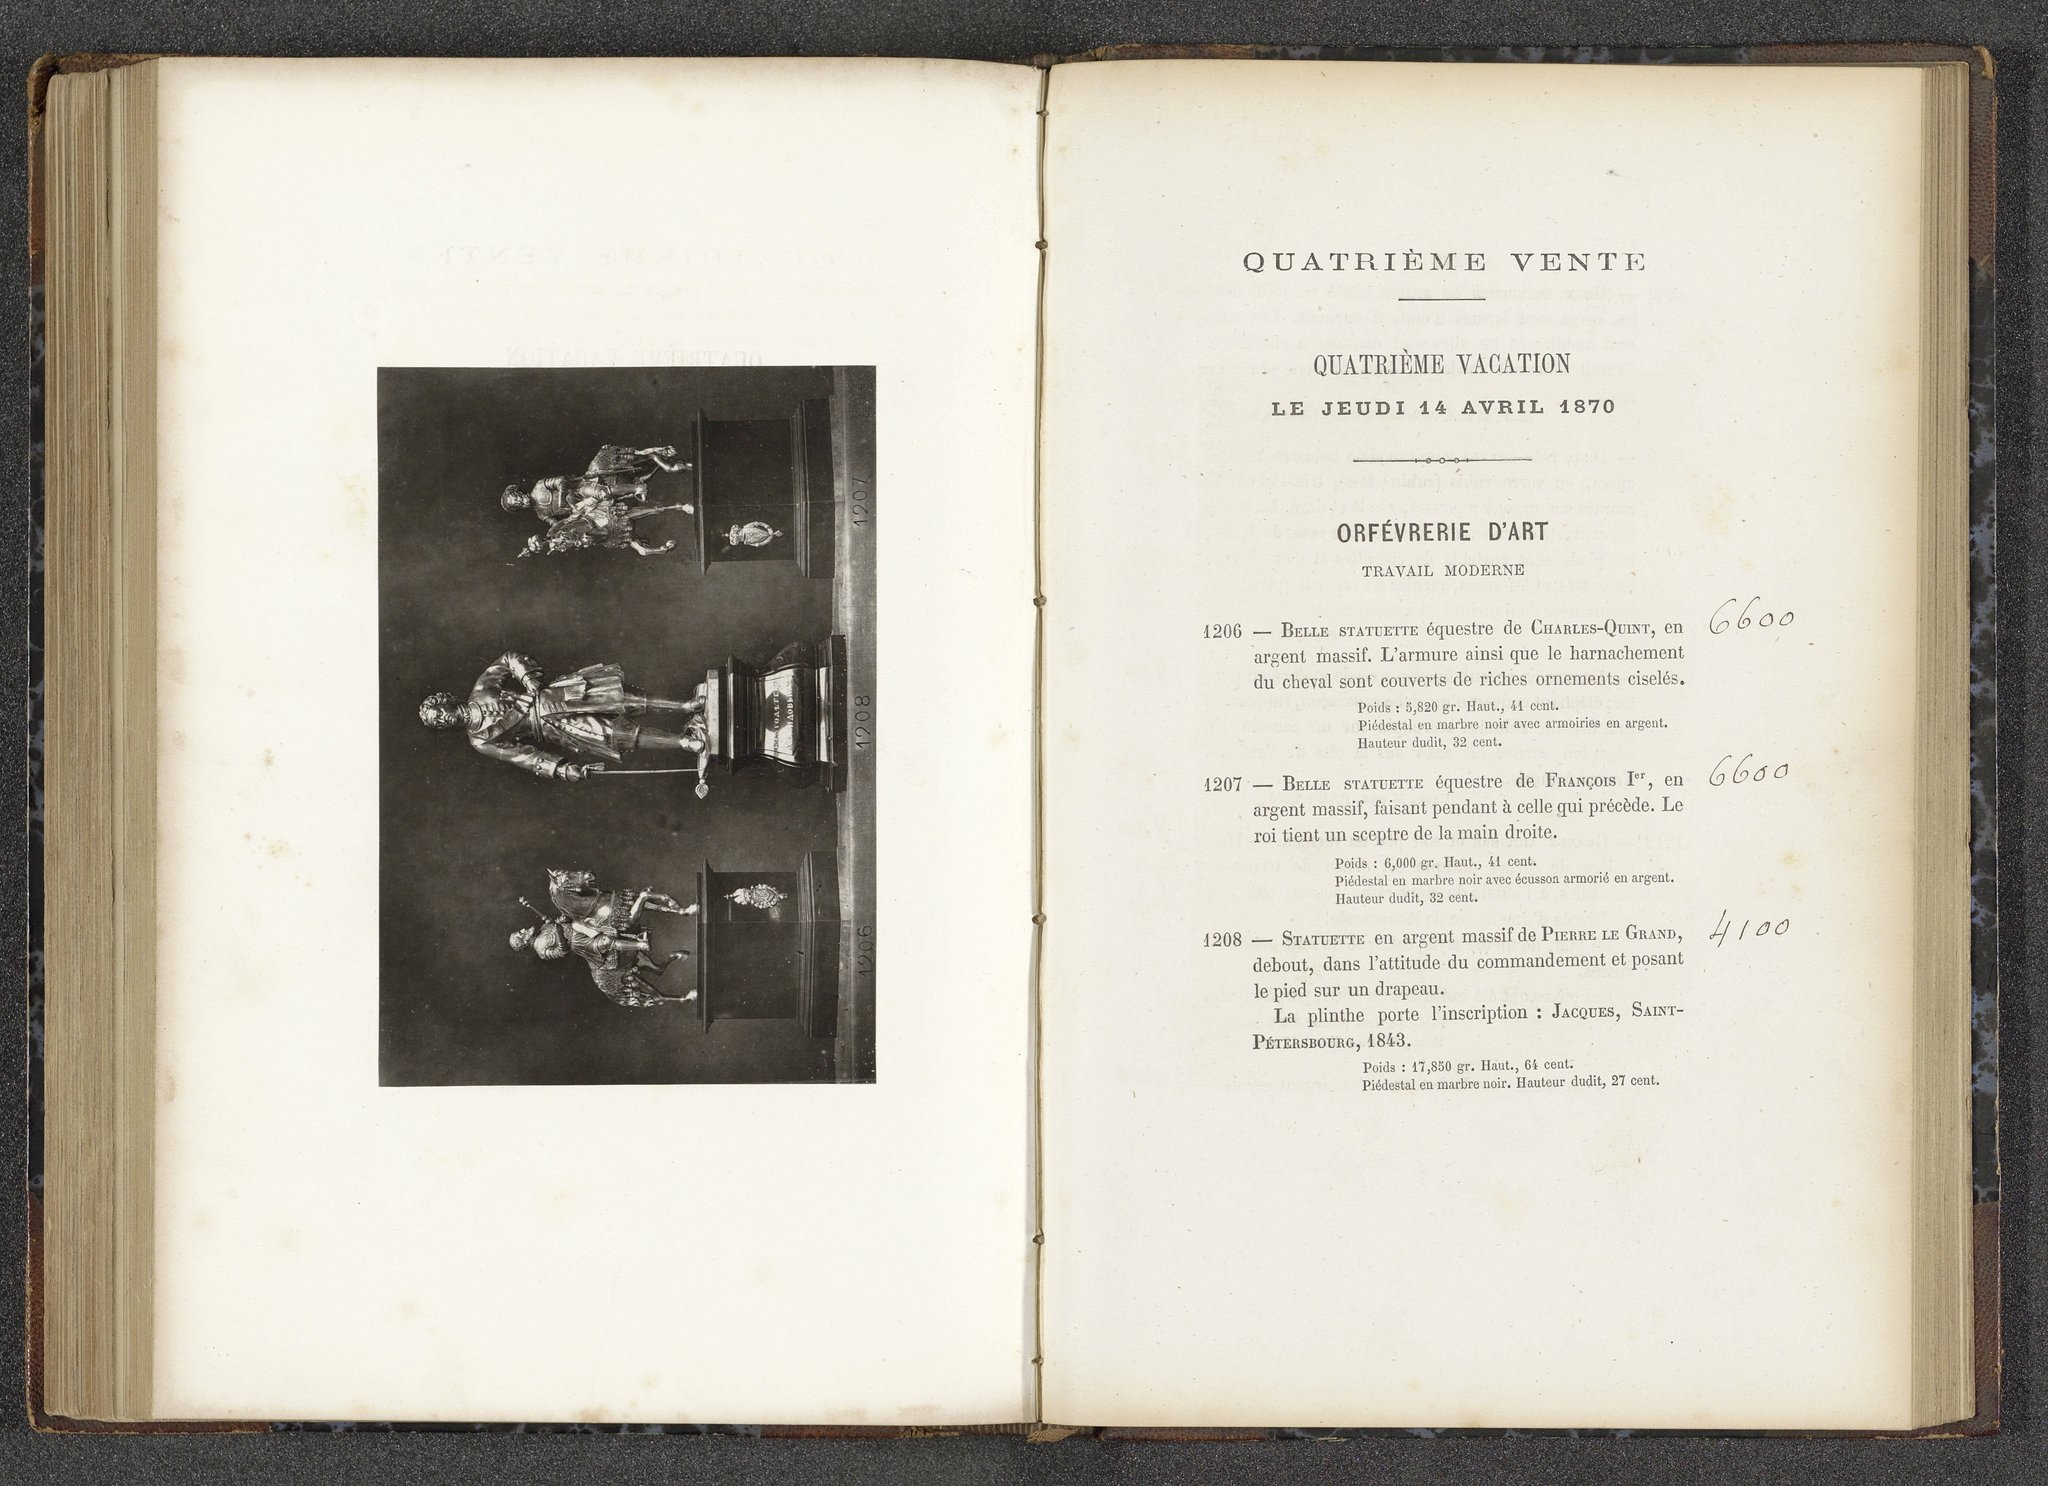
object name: page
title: Drie gouden sculpturen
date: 1870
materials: paper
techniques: woodburytype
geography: paris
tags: peter i de grote (tsaar van rusland), frans i van valois-angoulême (koning van frankrijk), ghent, charles v (holy roman emperor and king of spain), monument, statue, equestrian statue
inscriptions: name: ‘De Goupil & Cie Imp. Photoglytique Paris’, number: ‘1206 1207 1208’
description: Links: ruiterstandbeeld van Keizer Karel V, midden: standbeeld van Peter I van Rusland, rechts: ruiterstandbeeld van Frans I van Frankrijk.